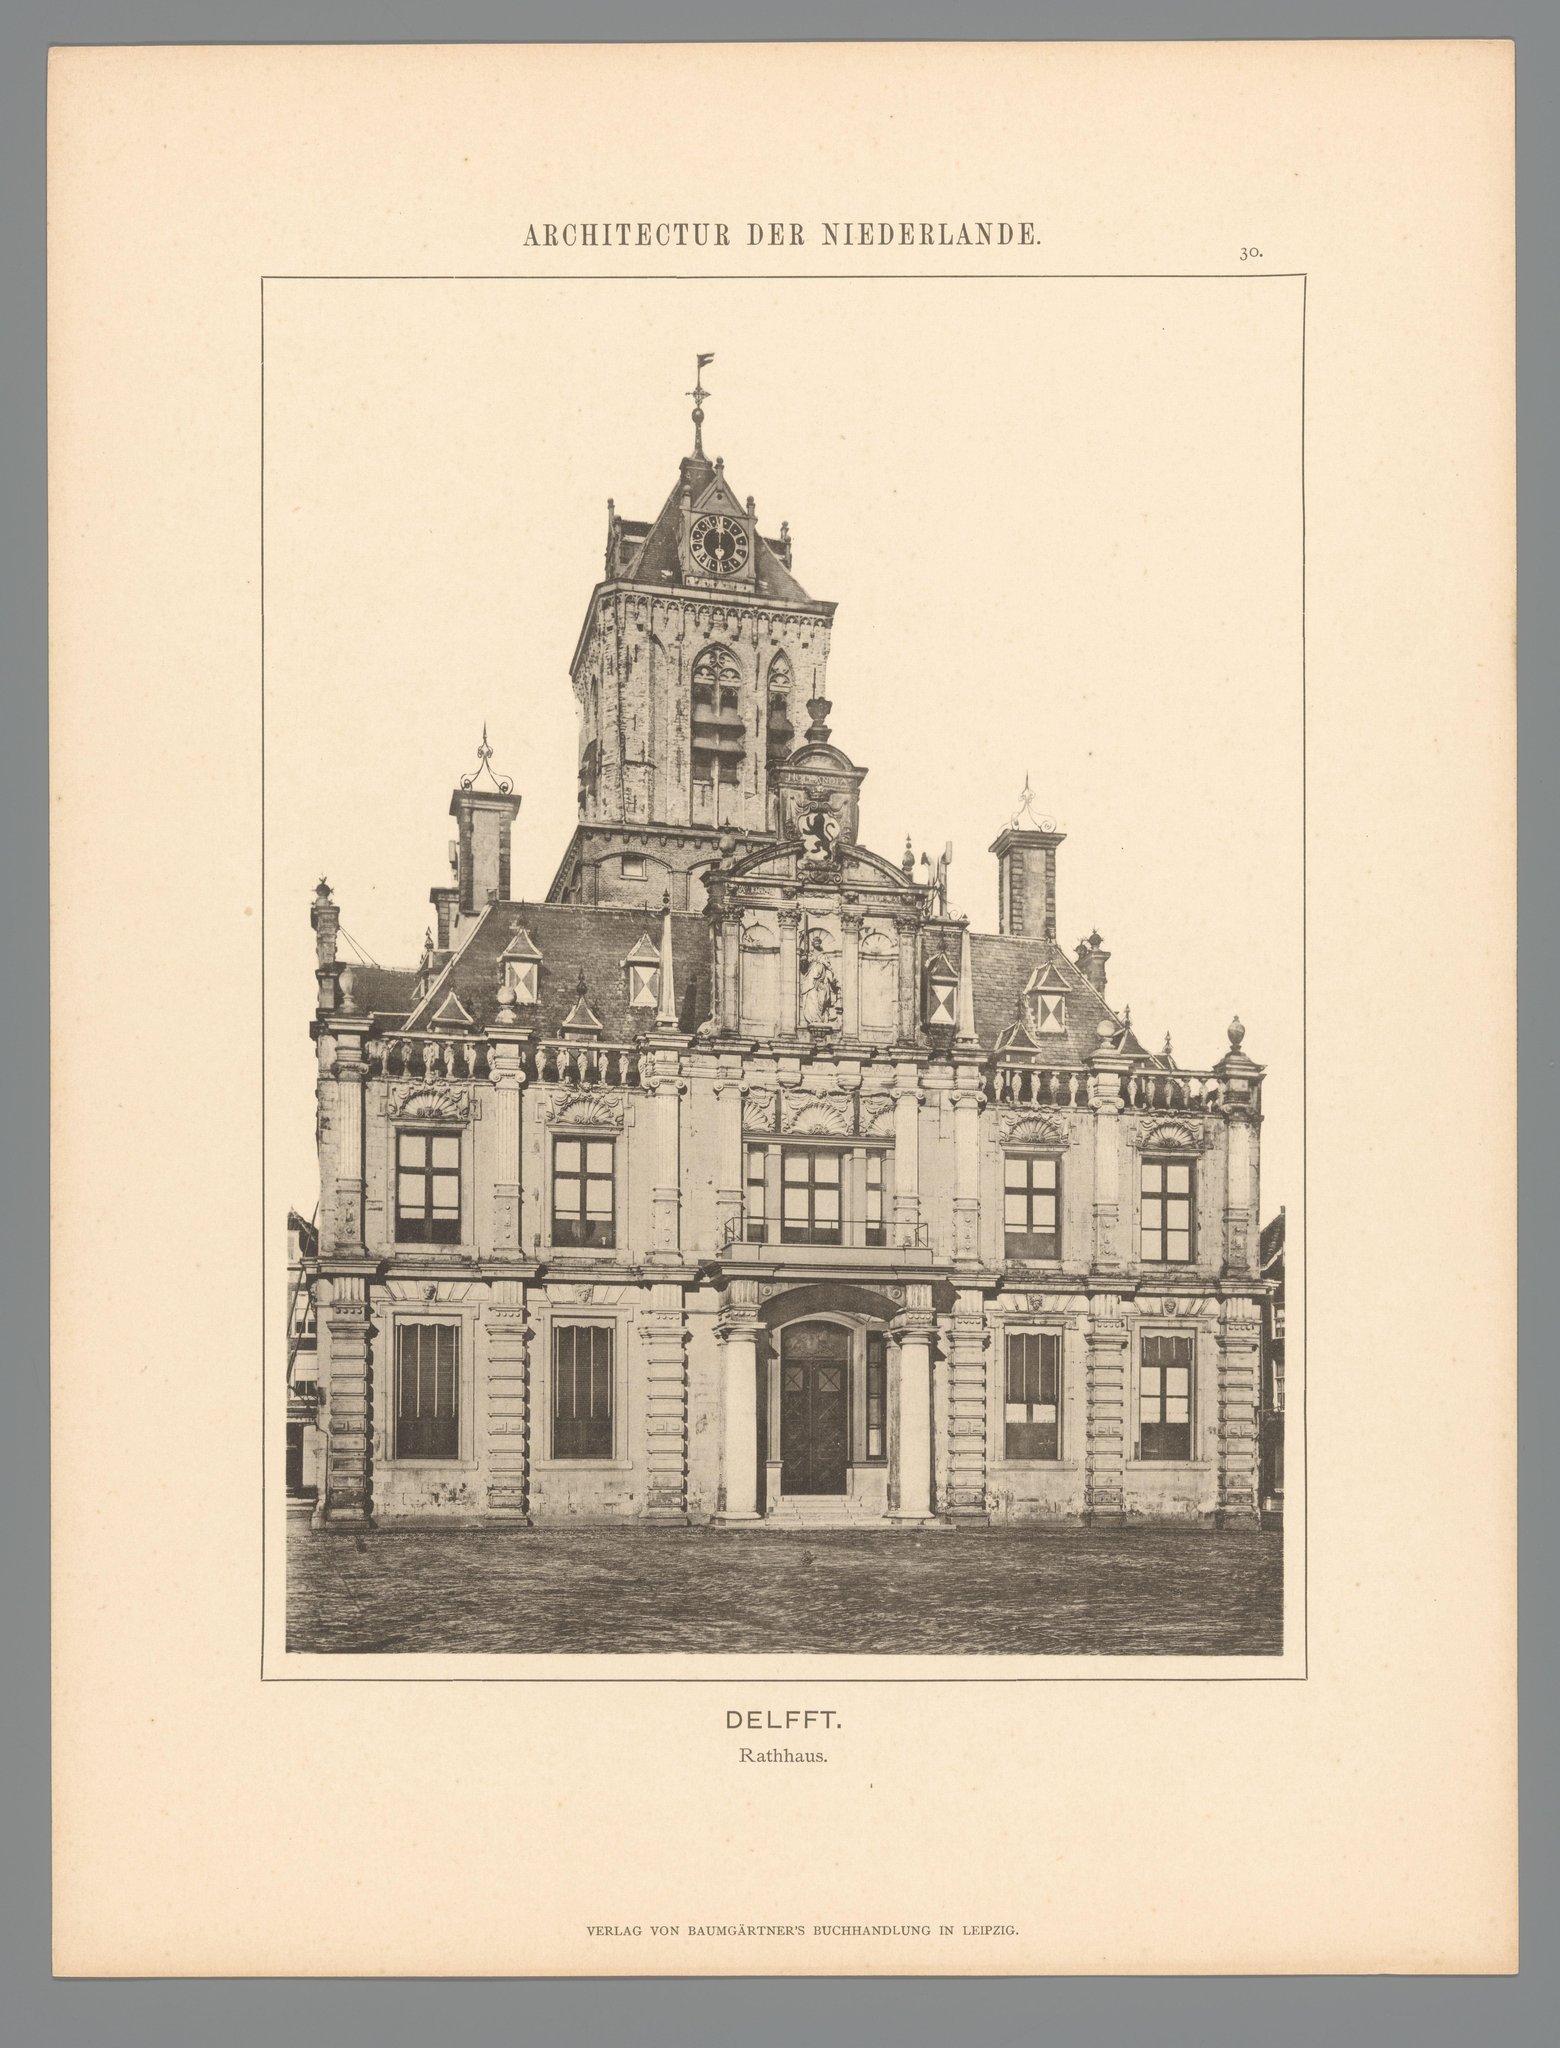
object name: photomechanical print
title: Gezicht op het stadhuis te Delft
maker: Anonymous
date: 1894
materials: paper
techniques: photograph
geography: leipzig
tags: townhall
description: Afdruk uit: Krook, L. Architectur der Niederlande. Leipzig: Baumgärtner's Buchhandlung, 1894.